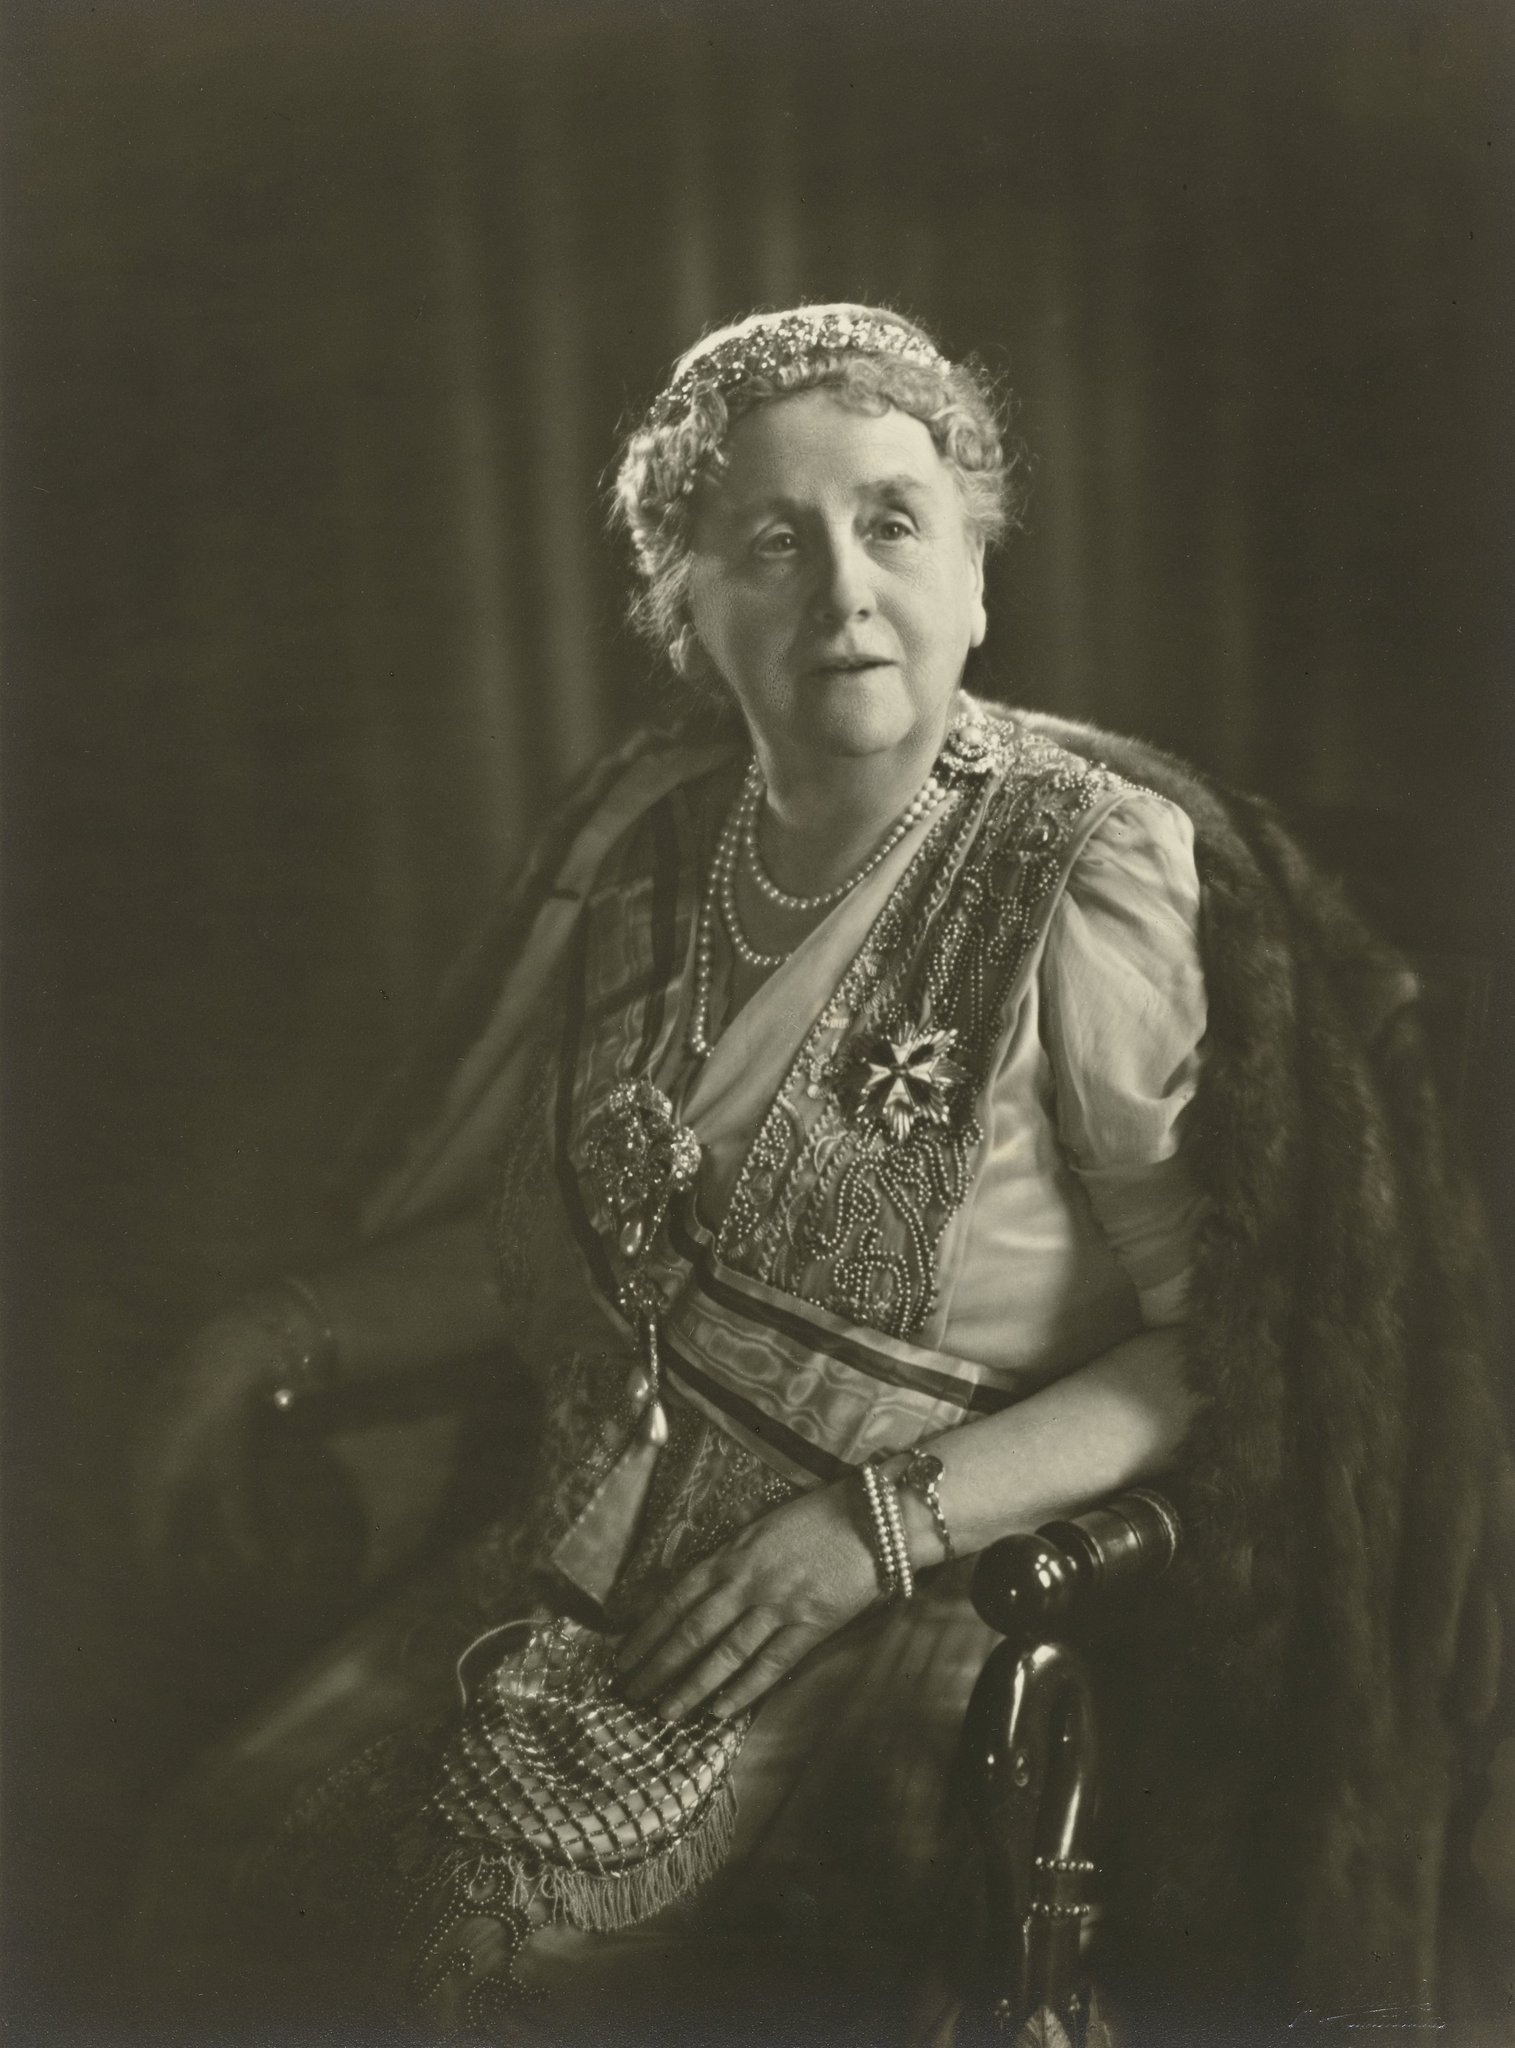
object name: photograph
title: Collectie Merkelbach, portretten van koningin Wilhelmina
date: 1948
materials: photographic support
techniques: photography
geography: amsterdam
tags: the hague, print maker, wilhelmina of the netherlands, amsterdam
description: Koningin Wilhelmina poseert met de Willemsorde. Kniestuk, zittend naar links, het hoofd naar rechts gewend.